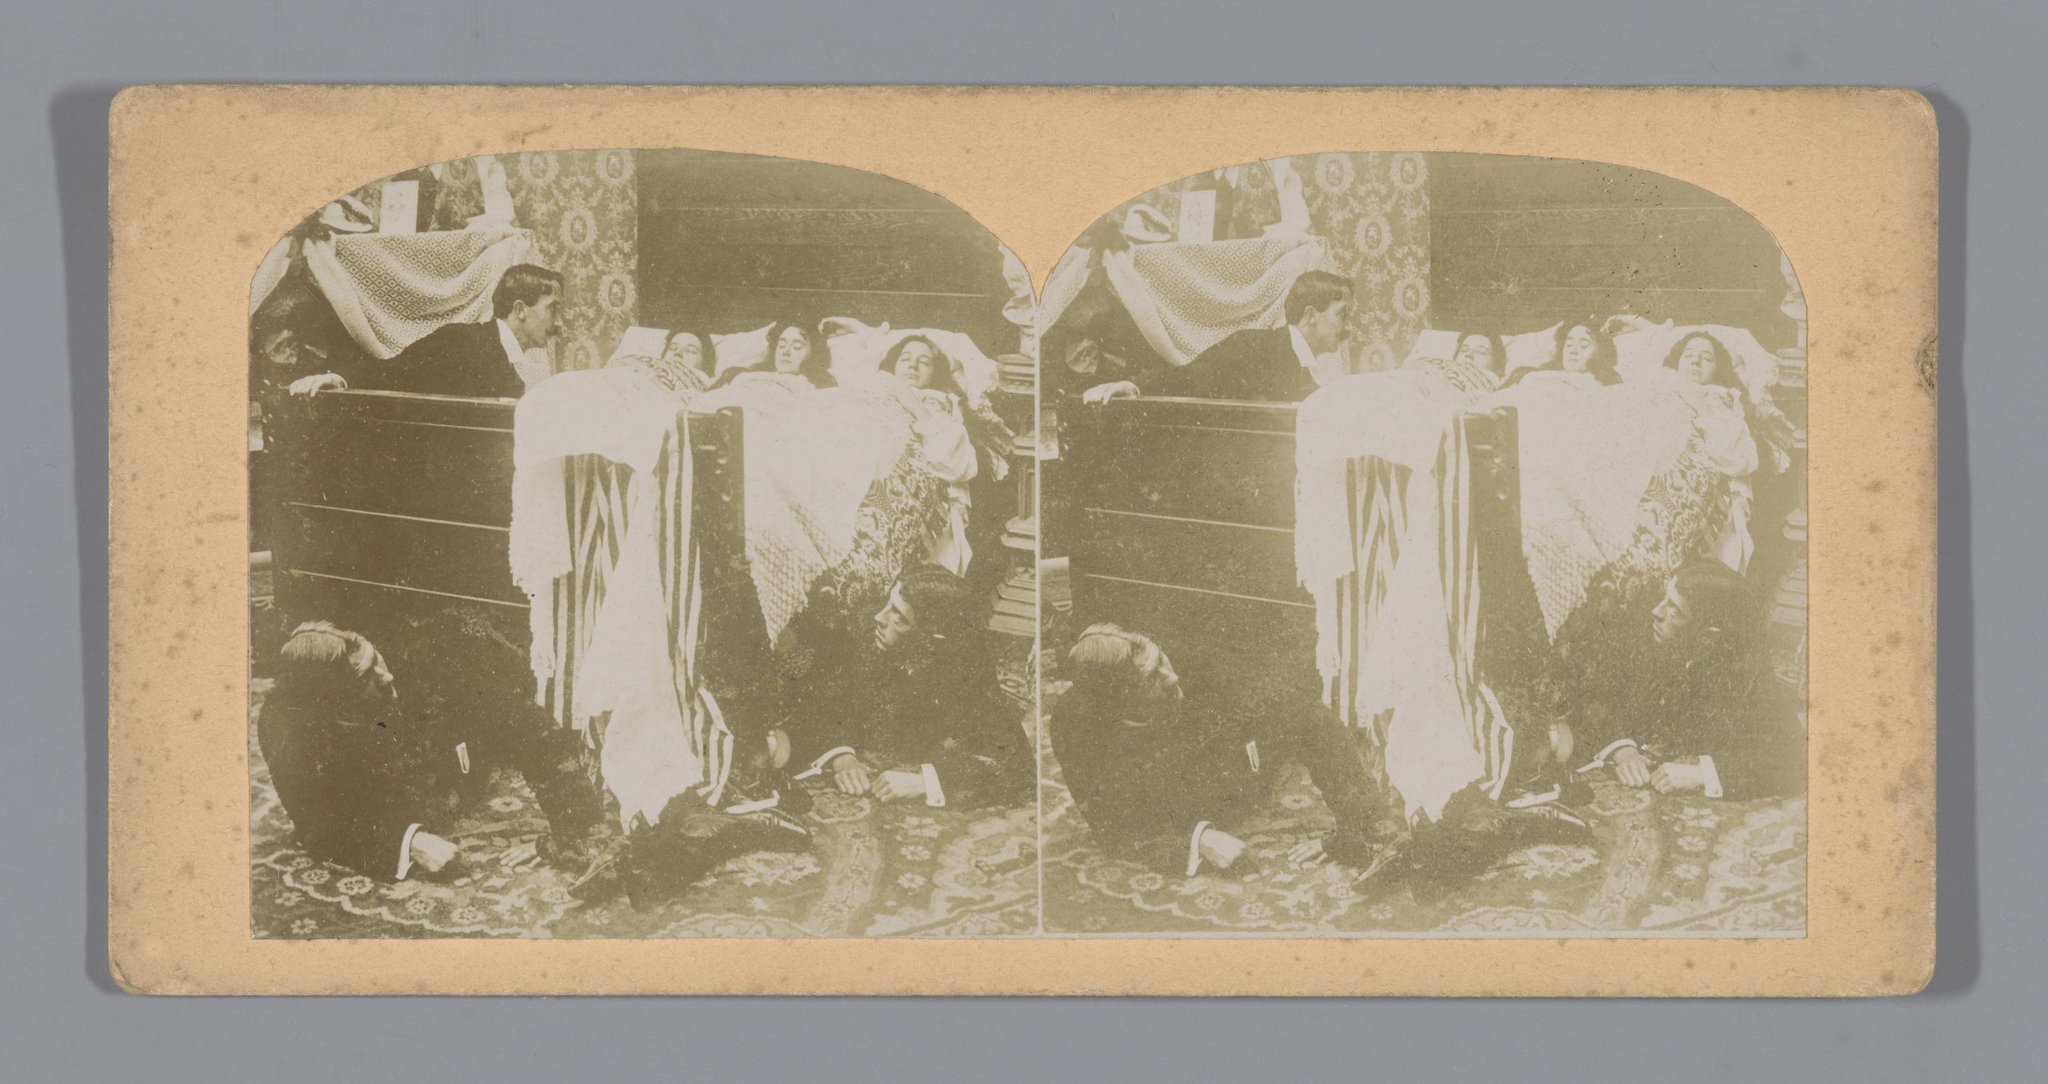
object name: stereograph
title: Theatrale voorstelling van drie meisjes in bed en drie mannen die eronder vandaan kruipen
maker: Anonymous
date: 1850-1880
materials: cardboard, photographic support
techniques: daylight paper print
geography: europe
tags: set, scenery ~ stage, bed, europe